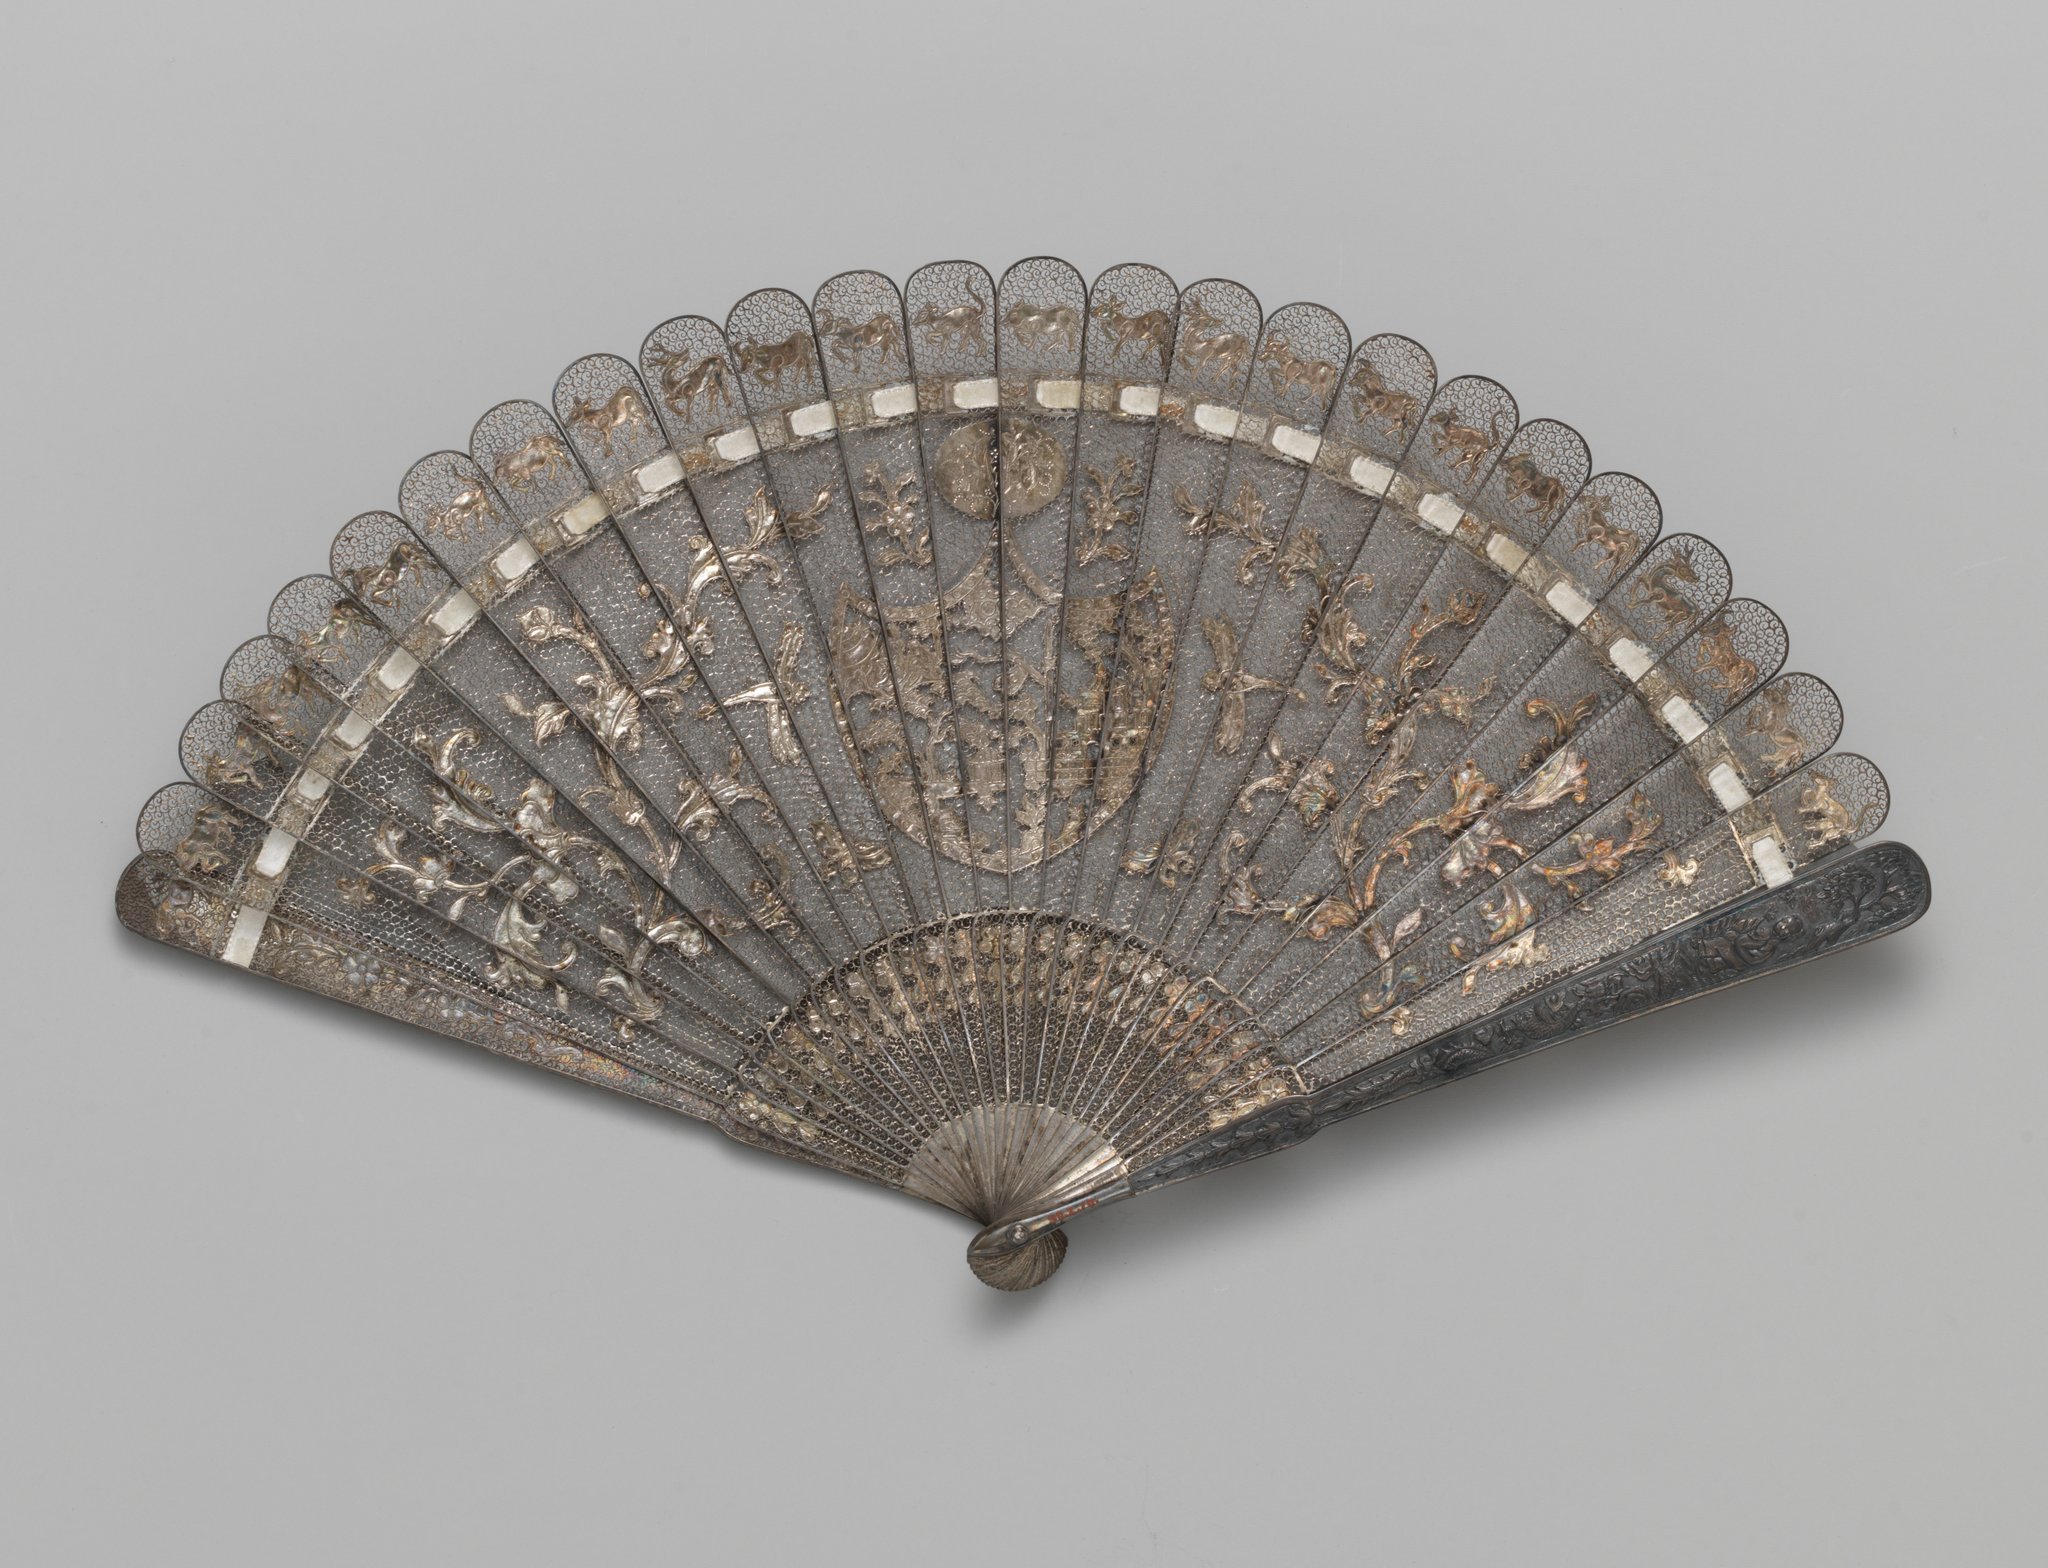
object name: fan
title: Brisé Fan with Representation of Pavilions in a Landscape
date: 1801-1900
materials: silver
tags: shields